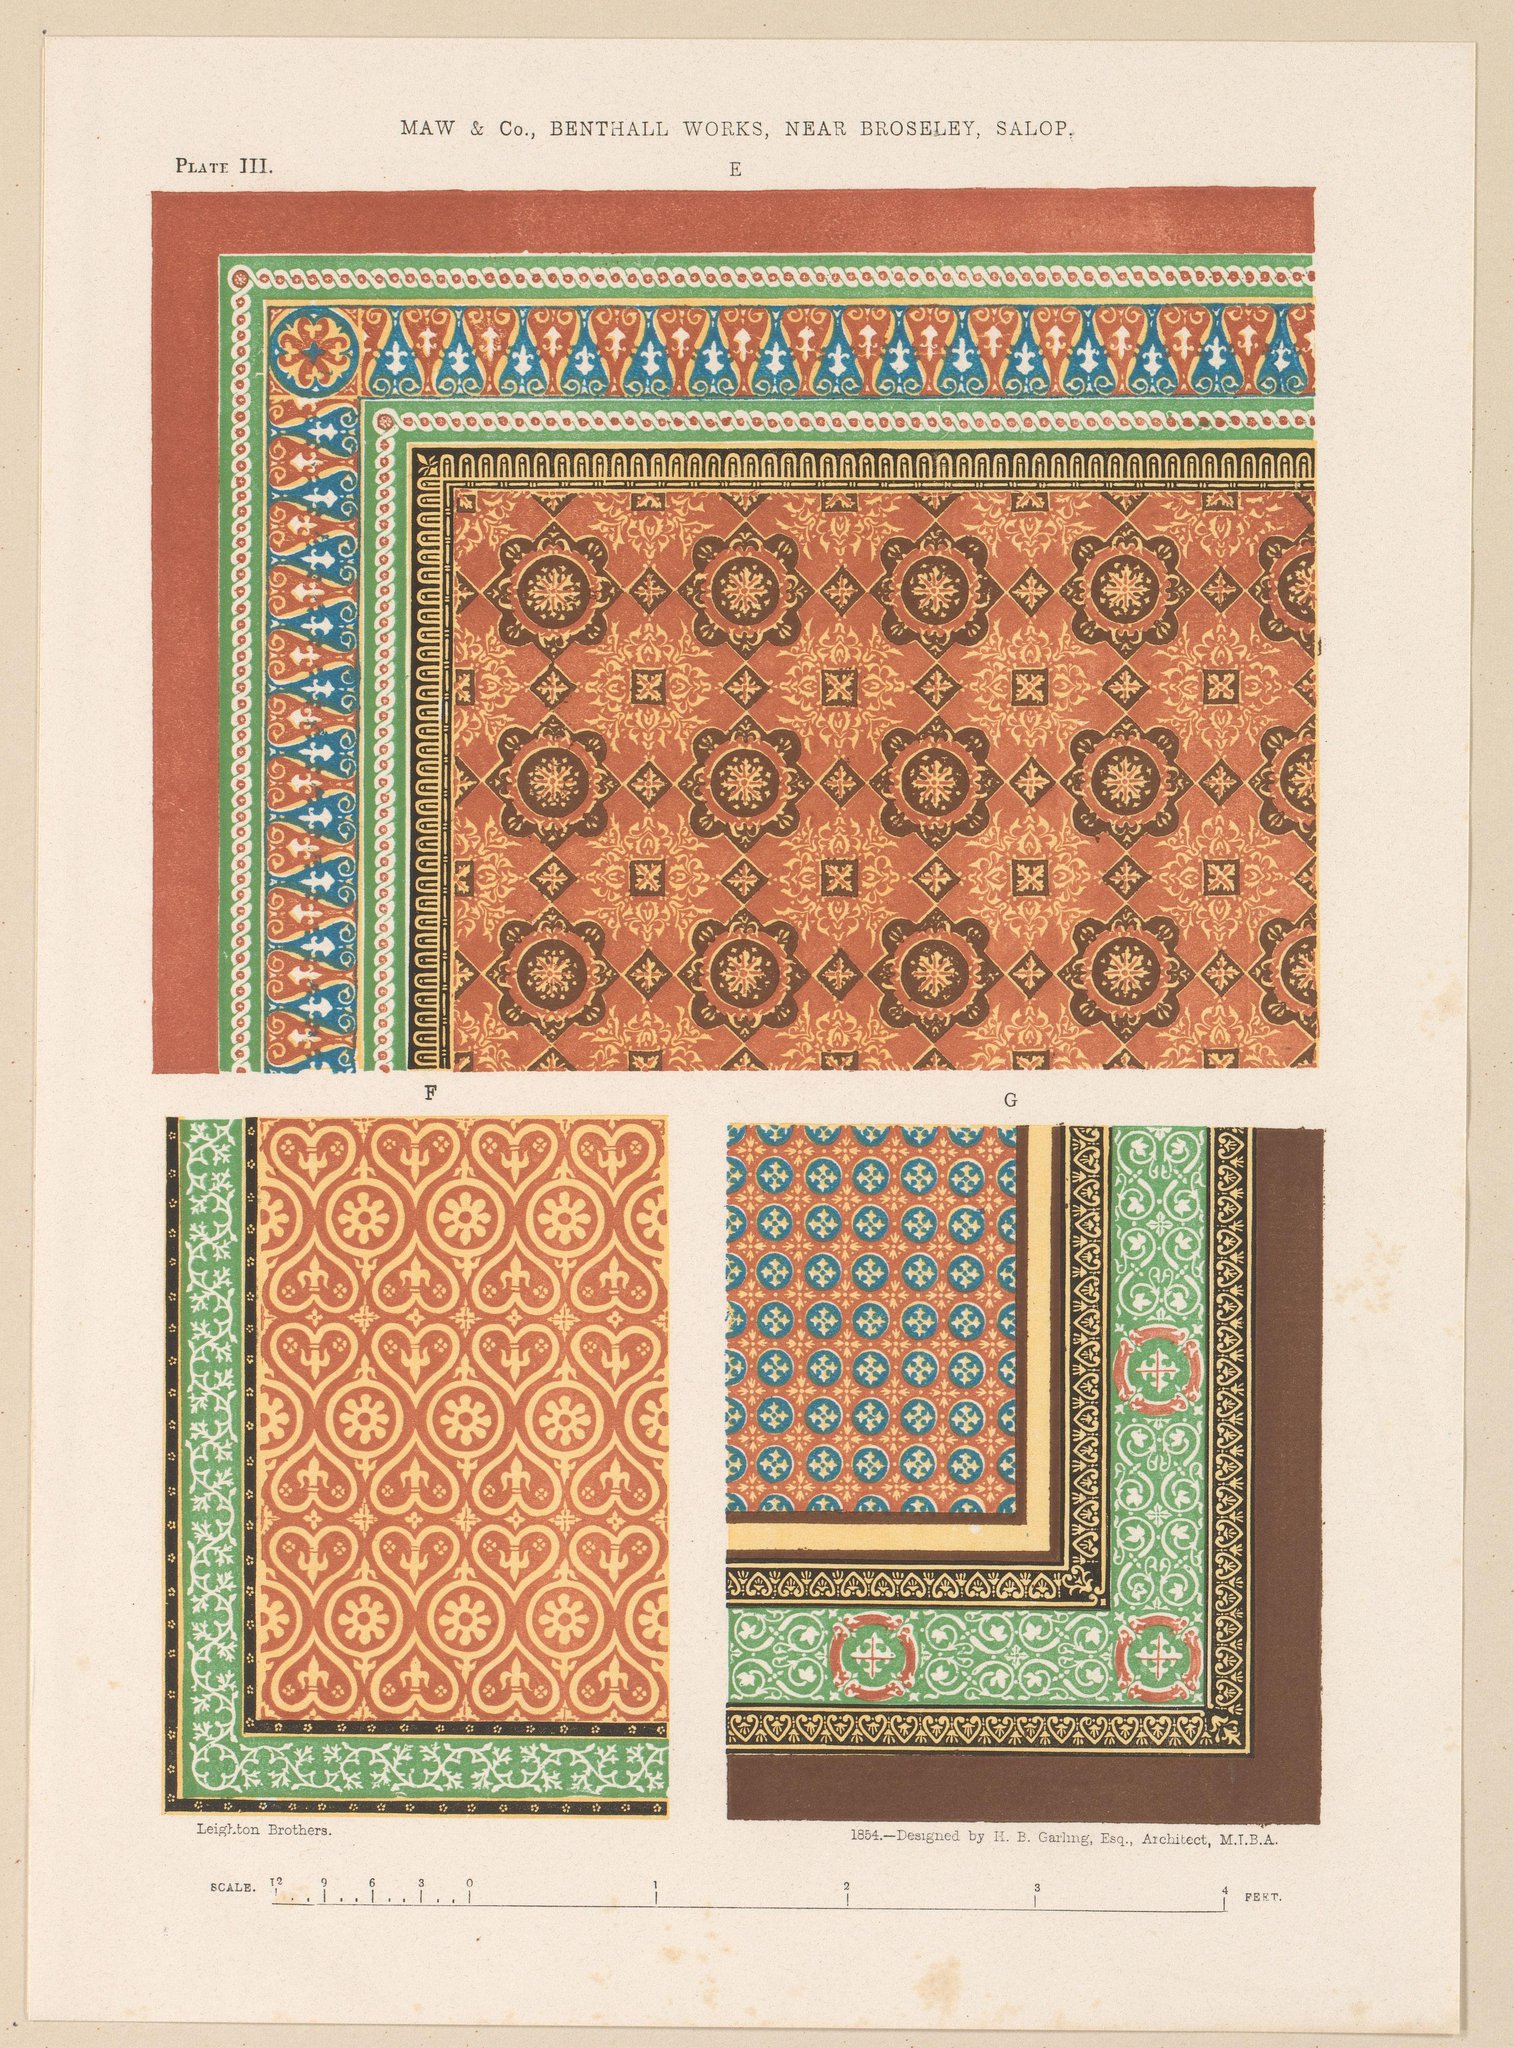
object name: print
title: Decoratiepatronen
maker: henry bayly garling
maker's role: designer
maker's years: 1822-1909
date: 1854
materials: paper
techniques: chromolithography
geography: england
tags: ornament ~ geometric motifs, tiles, bricks ~ building material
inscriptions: collector's mark: Lugt 2228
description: Patronen voor tegels. Plate III. Geproduceerd door 'Maw & Co, Benthall Works, near Broseley, Salop'.